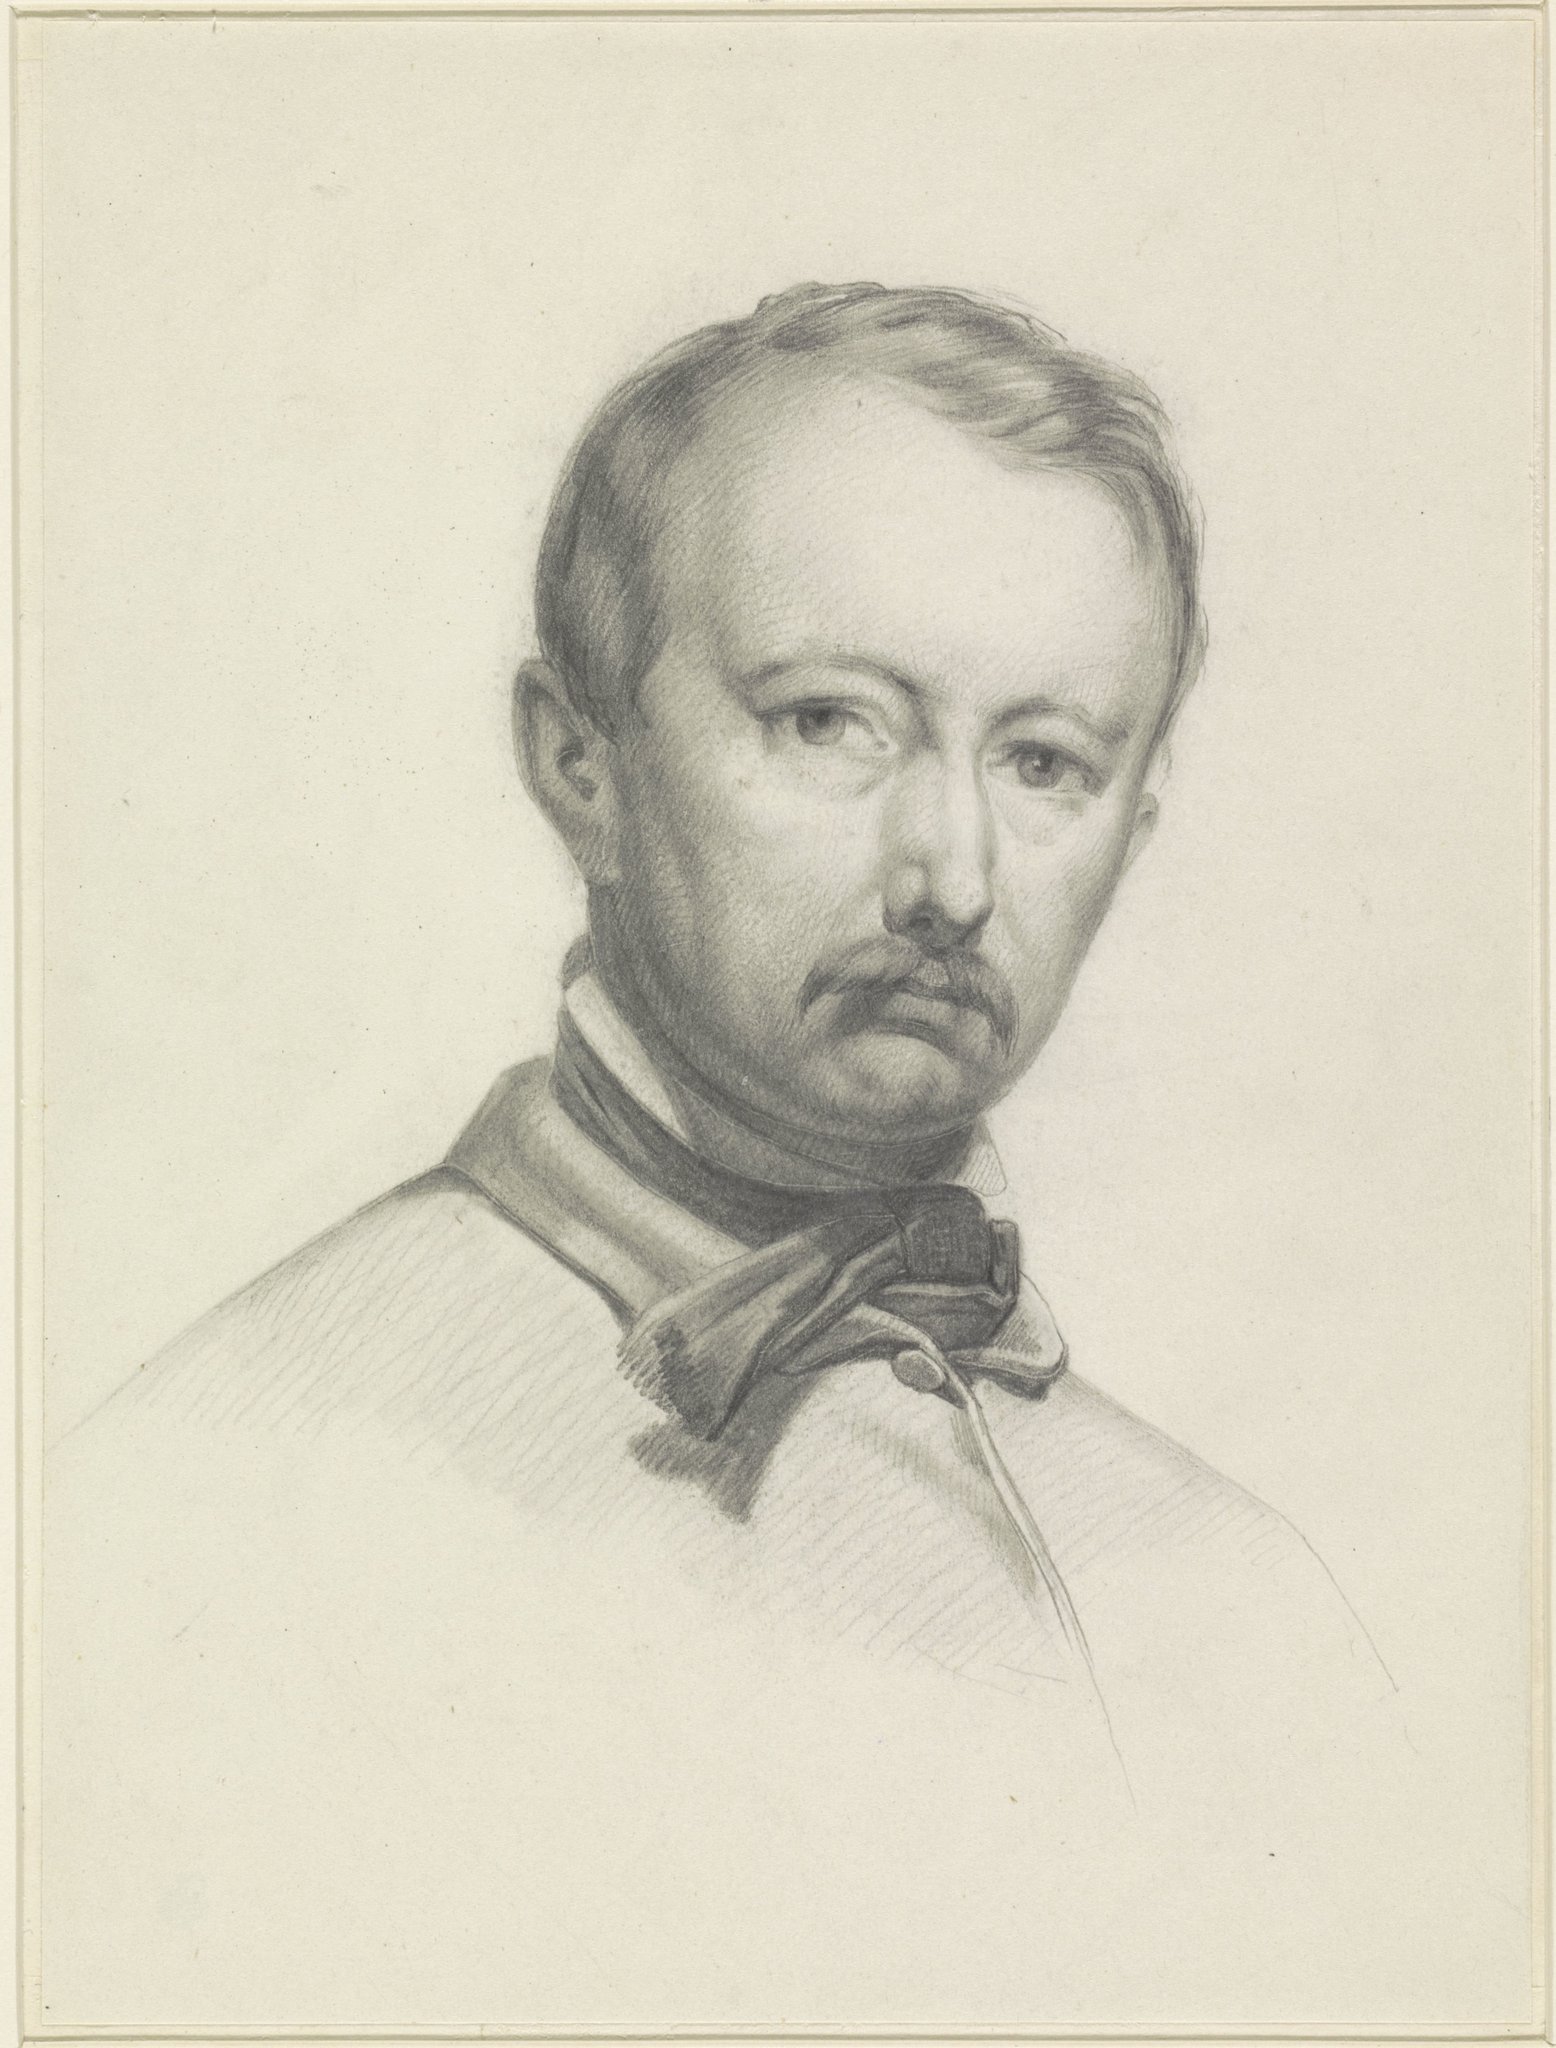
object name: drawing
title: Zelfportret van Jan Hendrik van de Laar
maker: jan hendrik van de laar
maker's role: draughtsman, print maker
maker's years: 1807-1874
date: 1817-1874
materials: paper, pencil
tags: rotterdam, print maker, jan hendrik van de laar, historical persons, portrait, self-portrait of artist